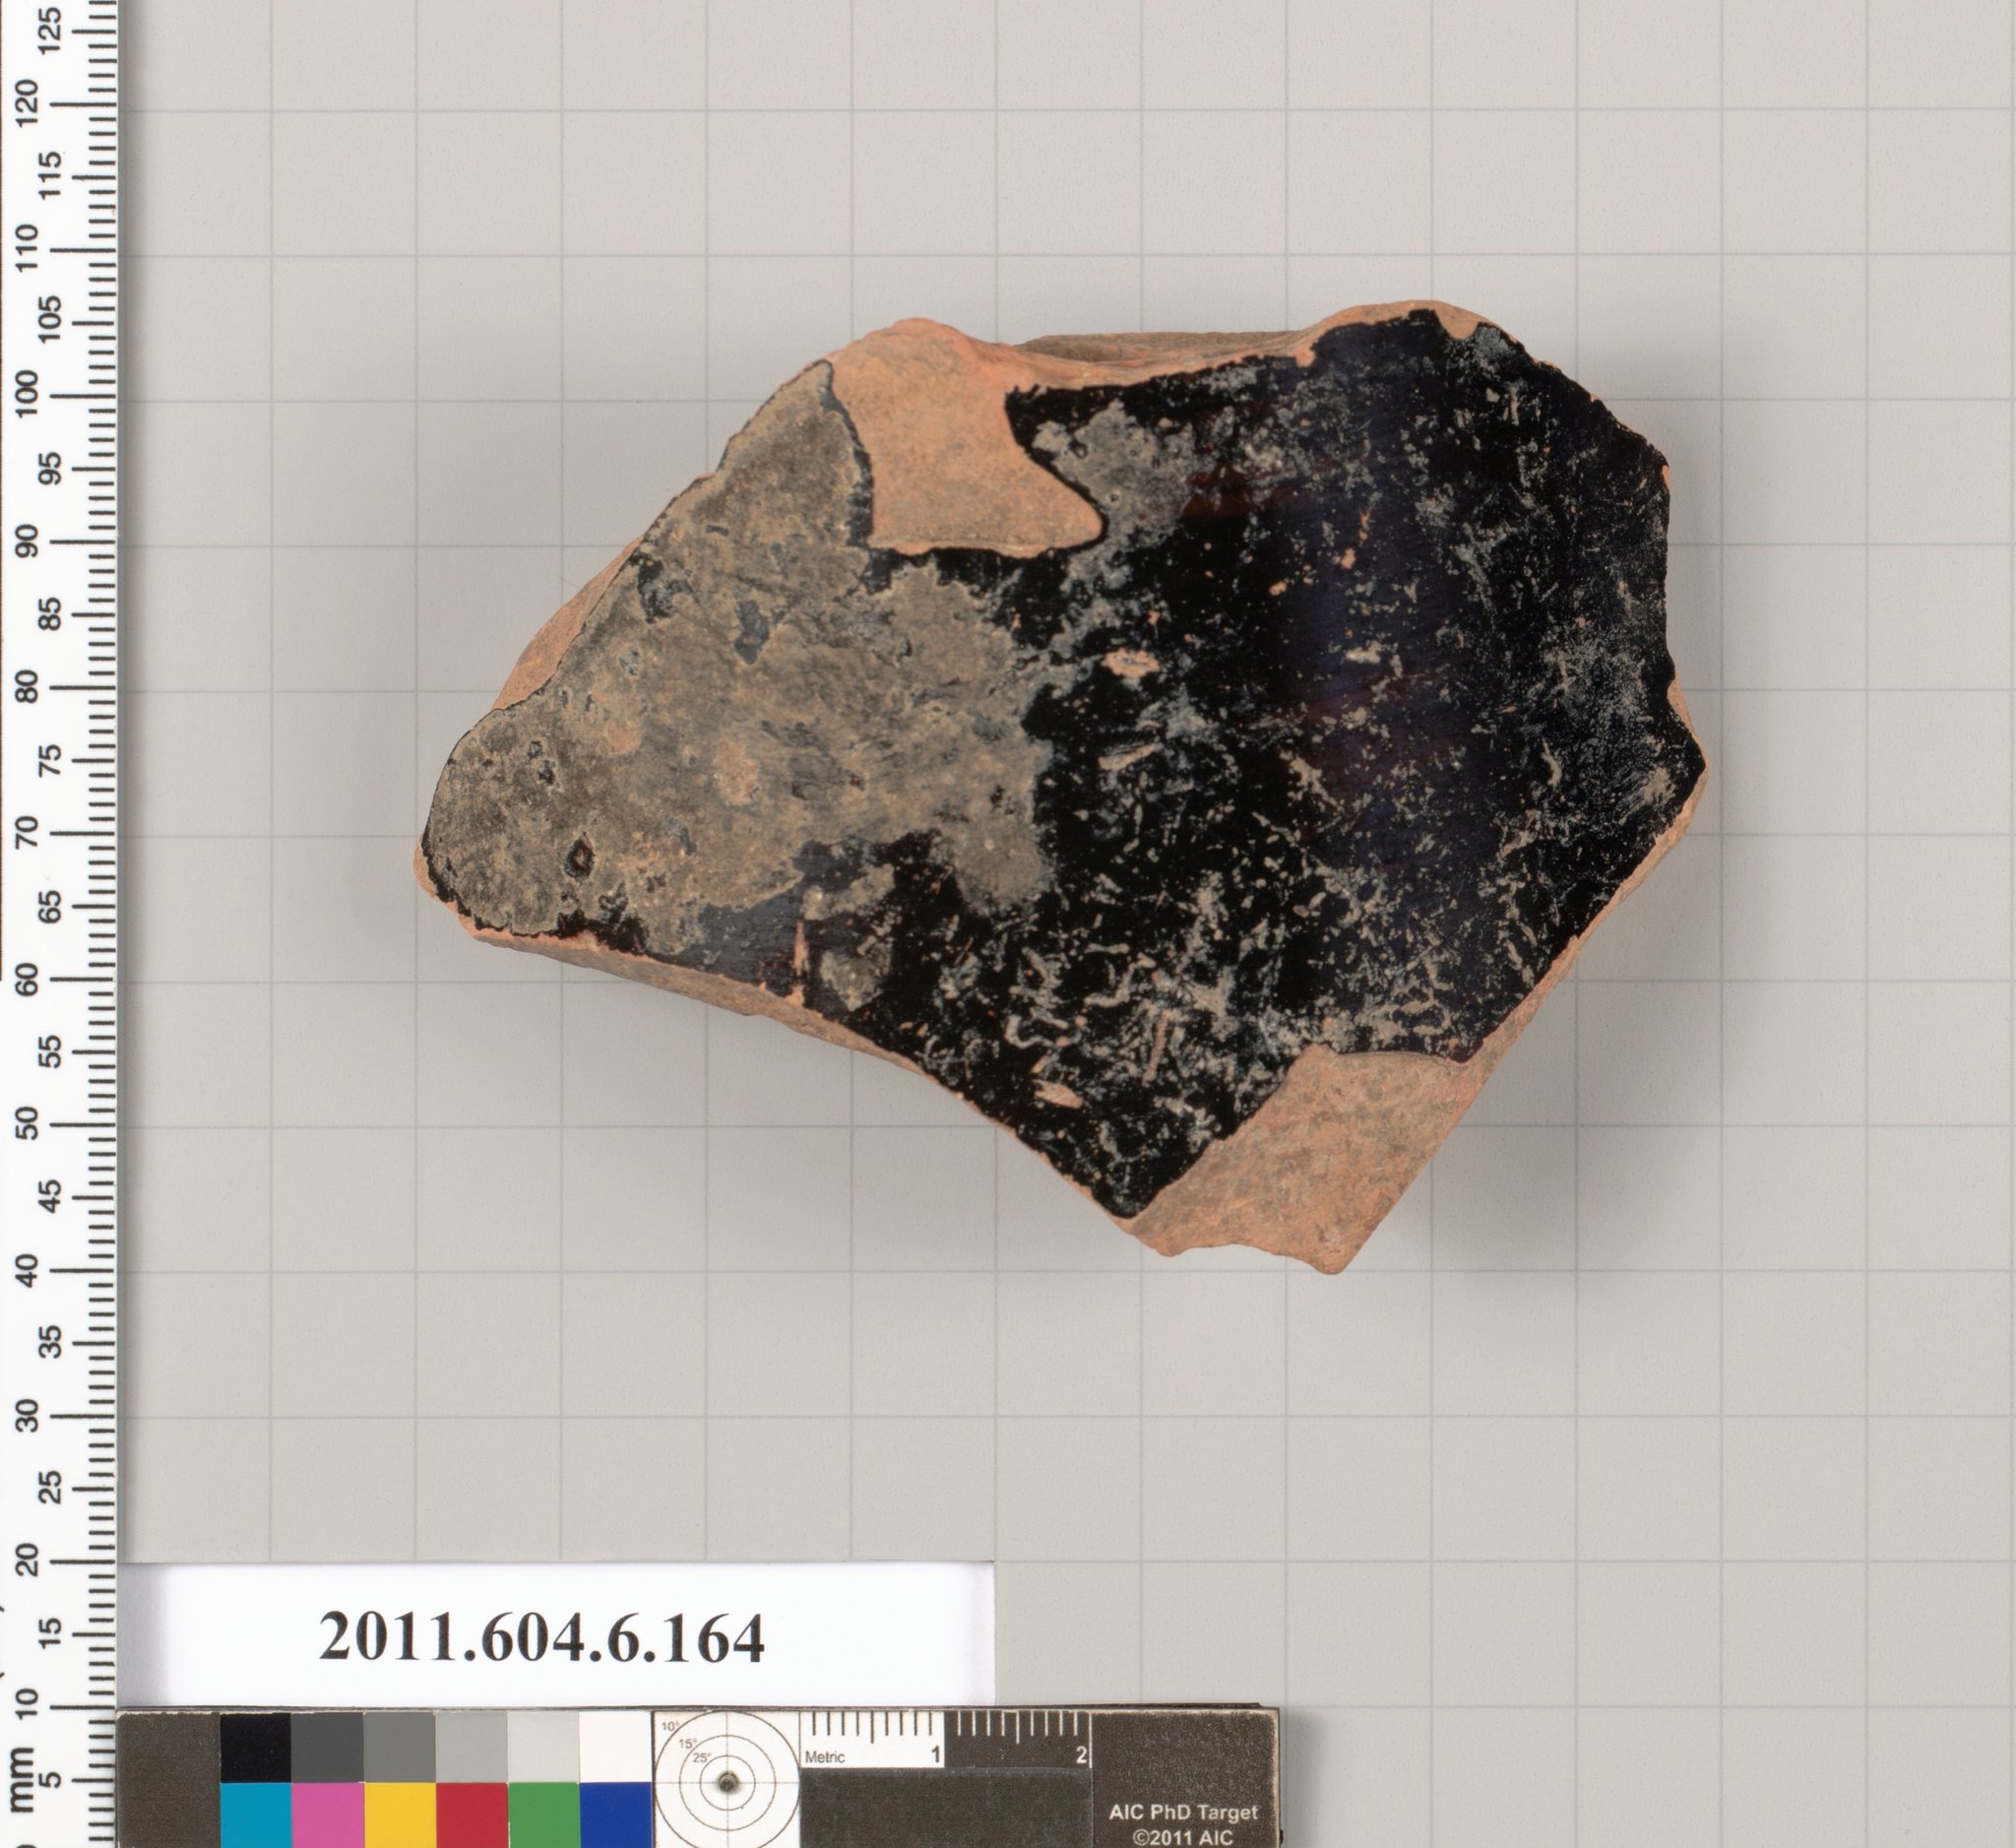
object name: undetermined closed shape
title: Terracotta fragment of a closed shape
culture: greek, attic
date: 600-401 BCE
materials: terracotta